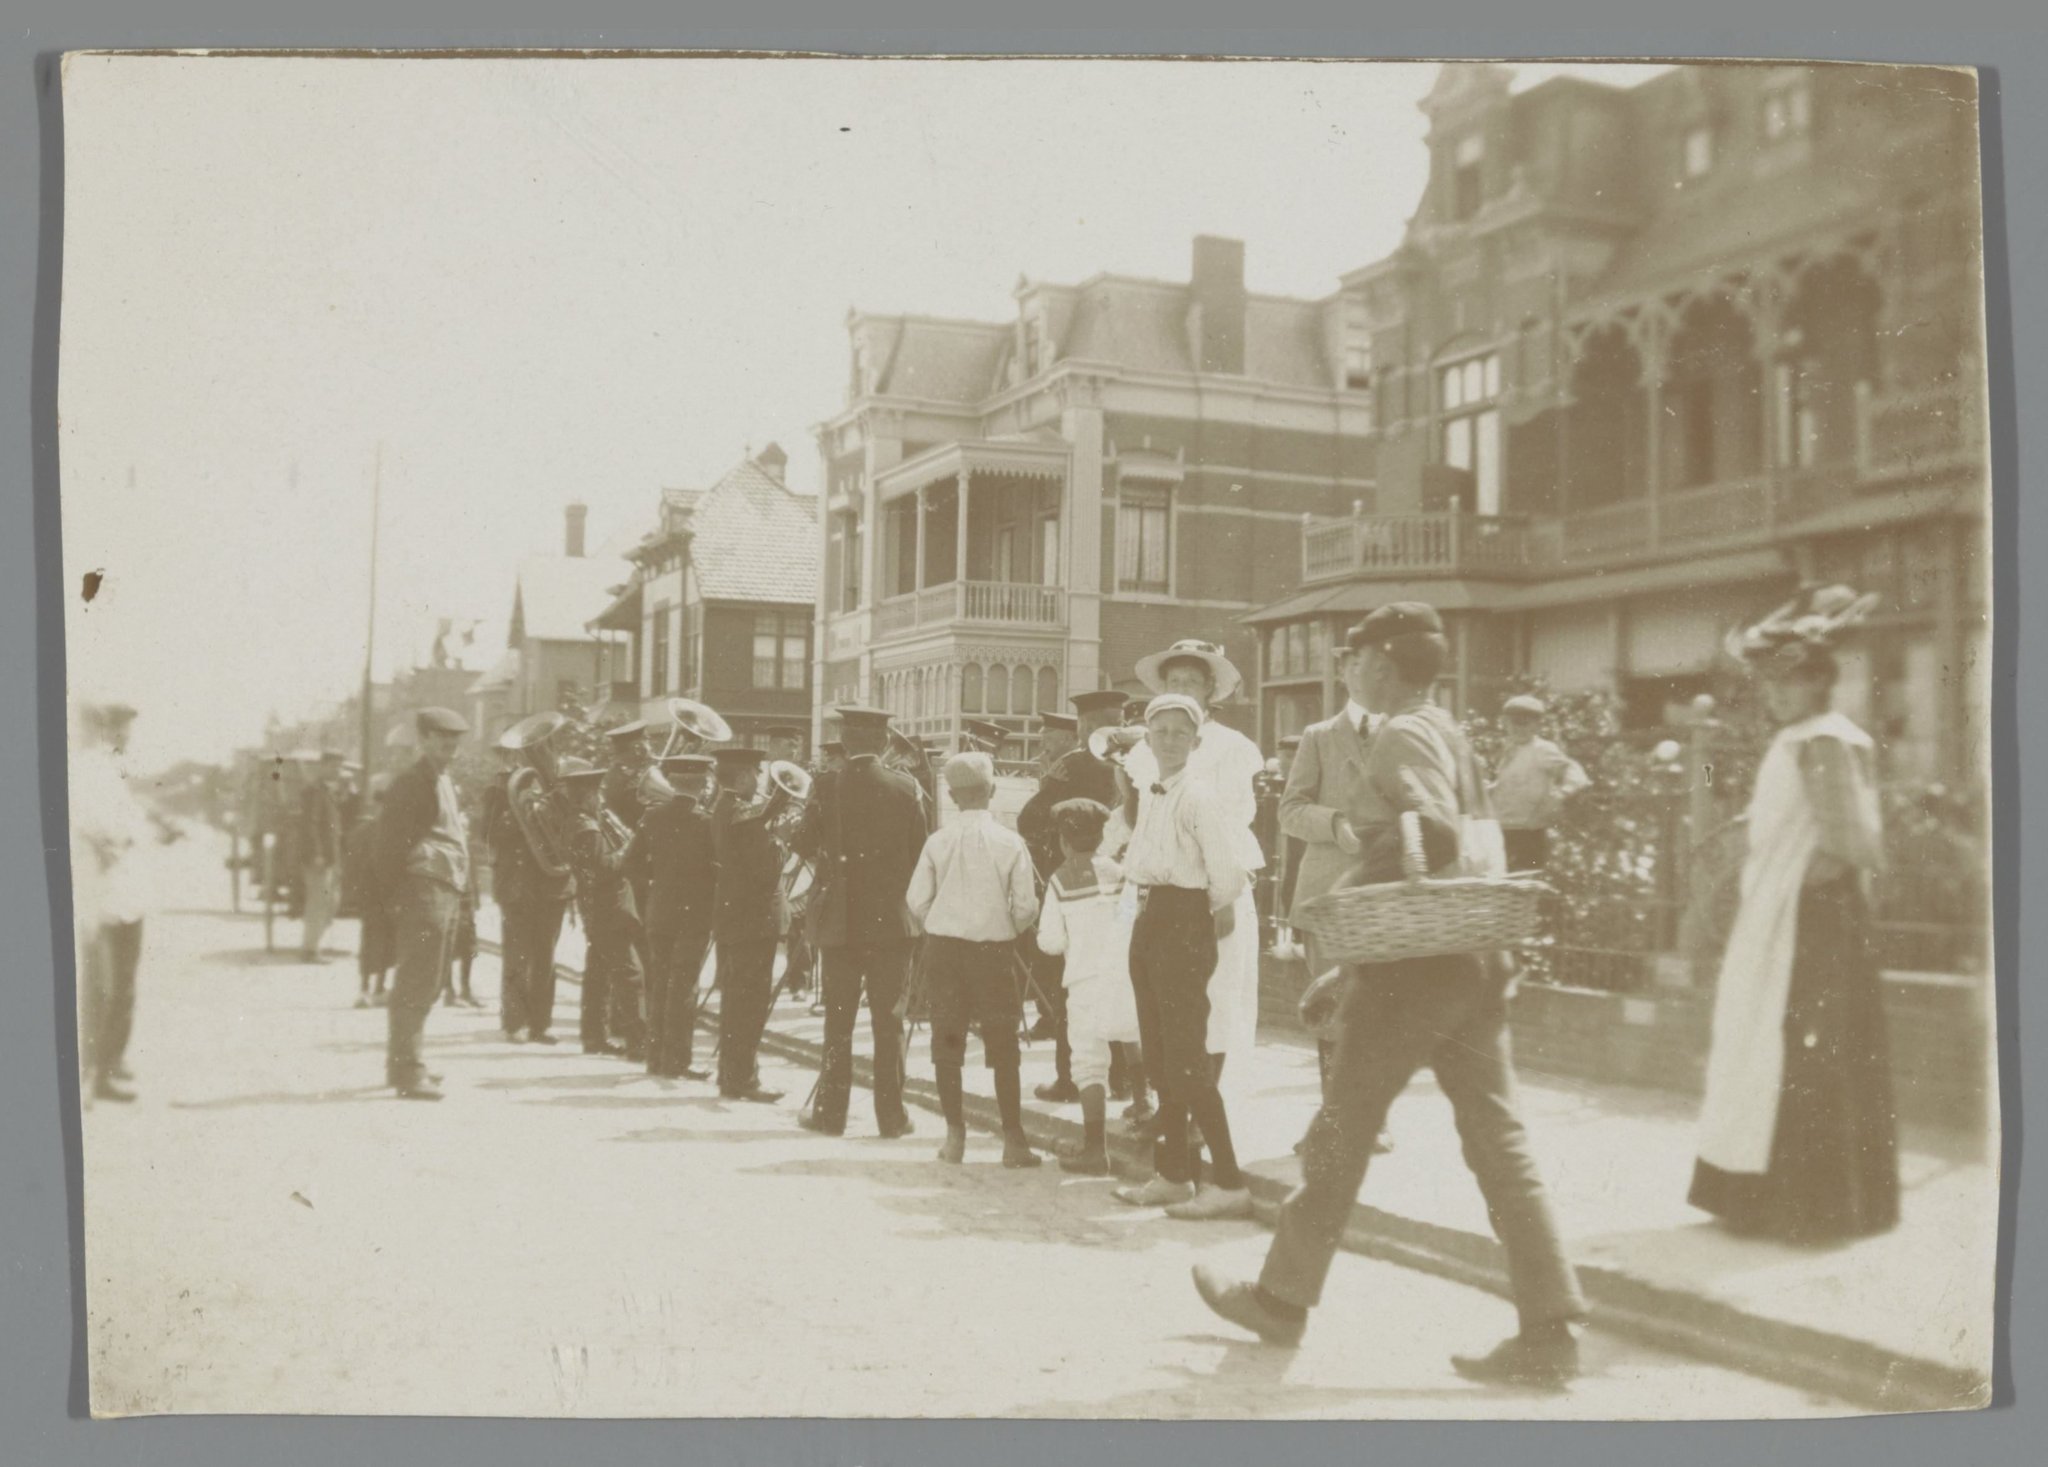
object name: photograph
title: Fanfare in een straat met villa's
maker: Anonymous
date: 1900-1910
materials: paper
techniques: gelatin silver print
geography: netherlands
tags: brass band, street band - cc - out of doors